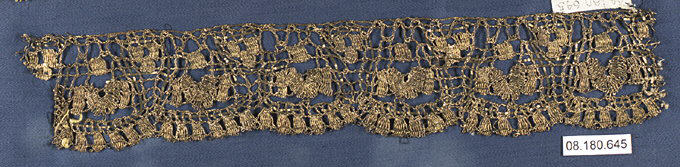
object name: fragment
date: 1601-1700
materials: metal thread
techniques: lace